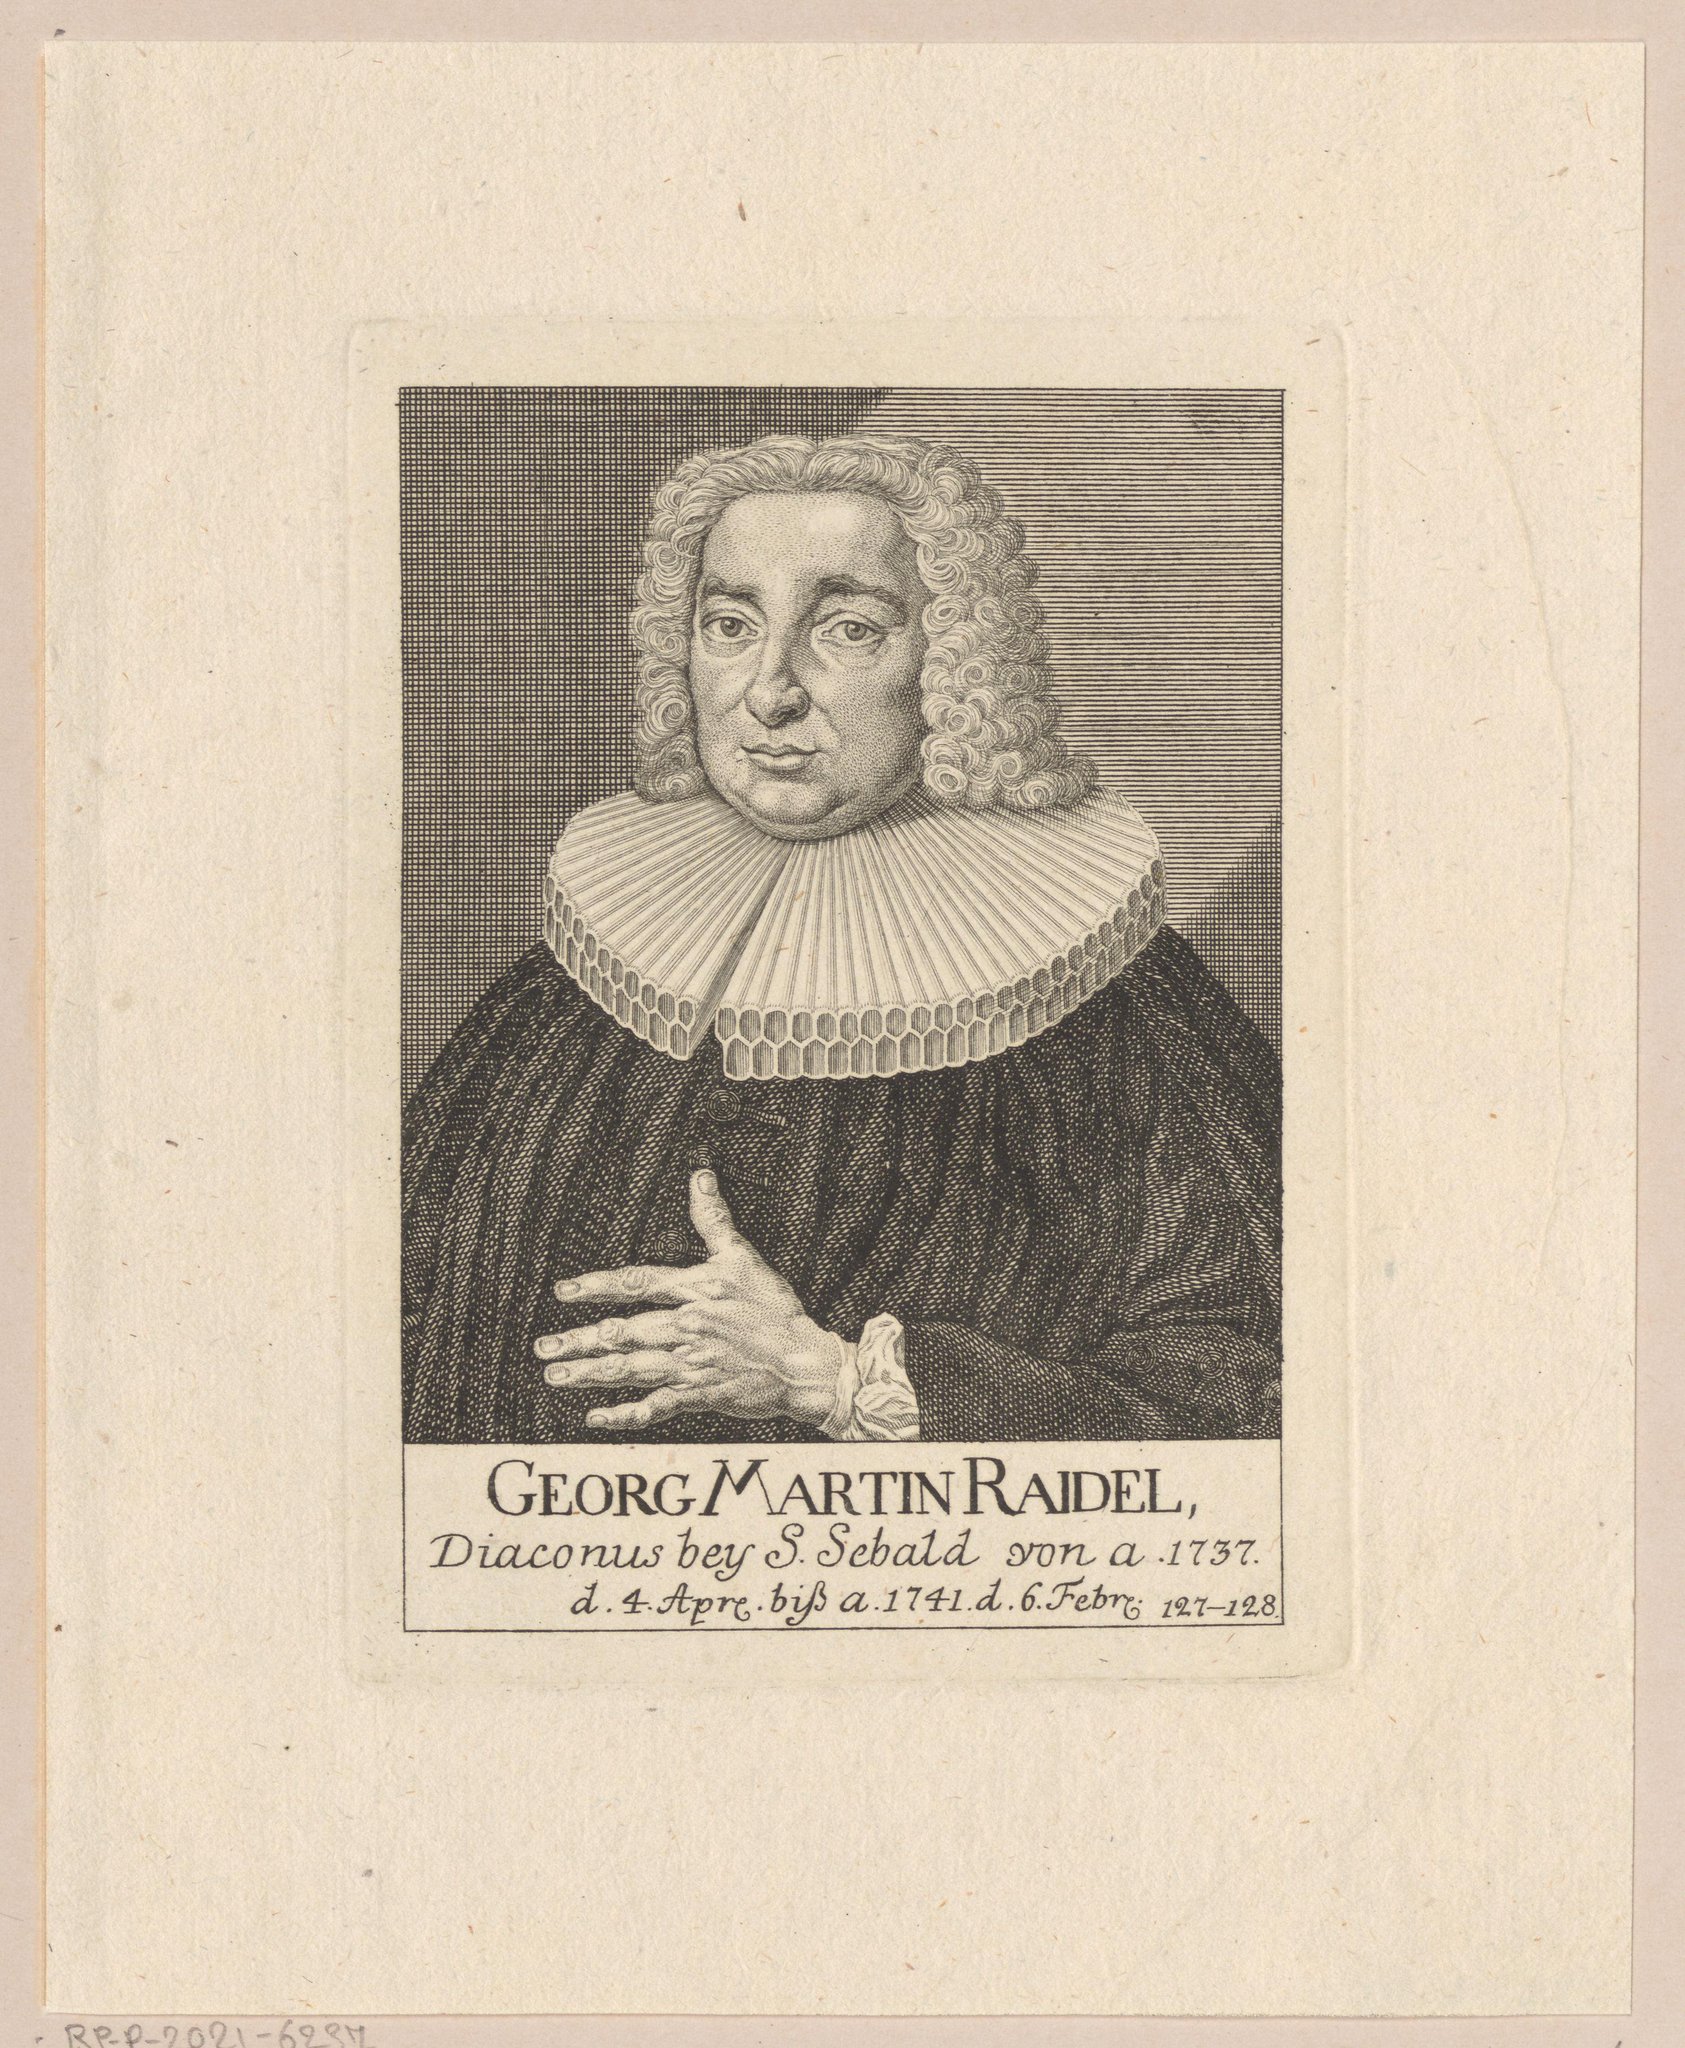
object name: print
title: Portret van Georg Martin Raidel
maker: Anonymous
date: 1741-1799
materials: paper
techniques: engraving, etching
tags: historical persons